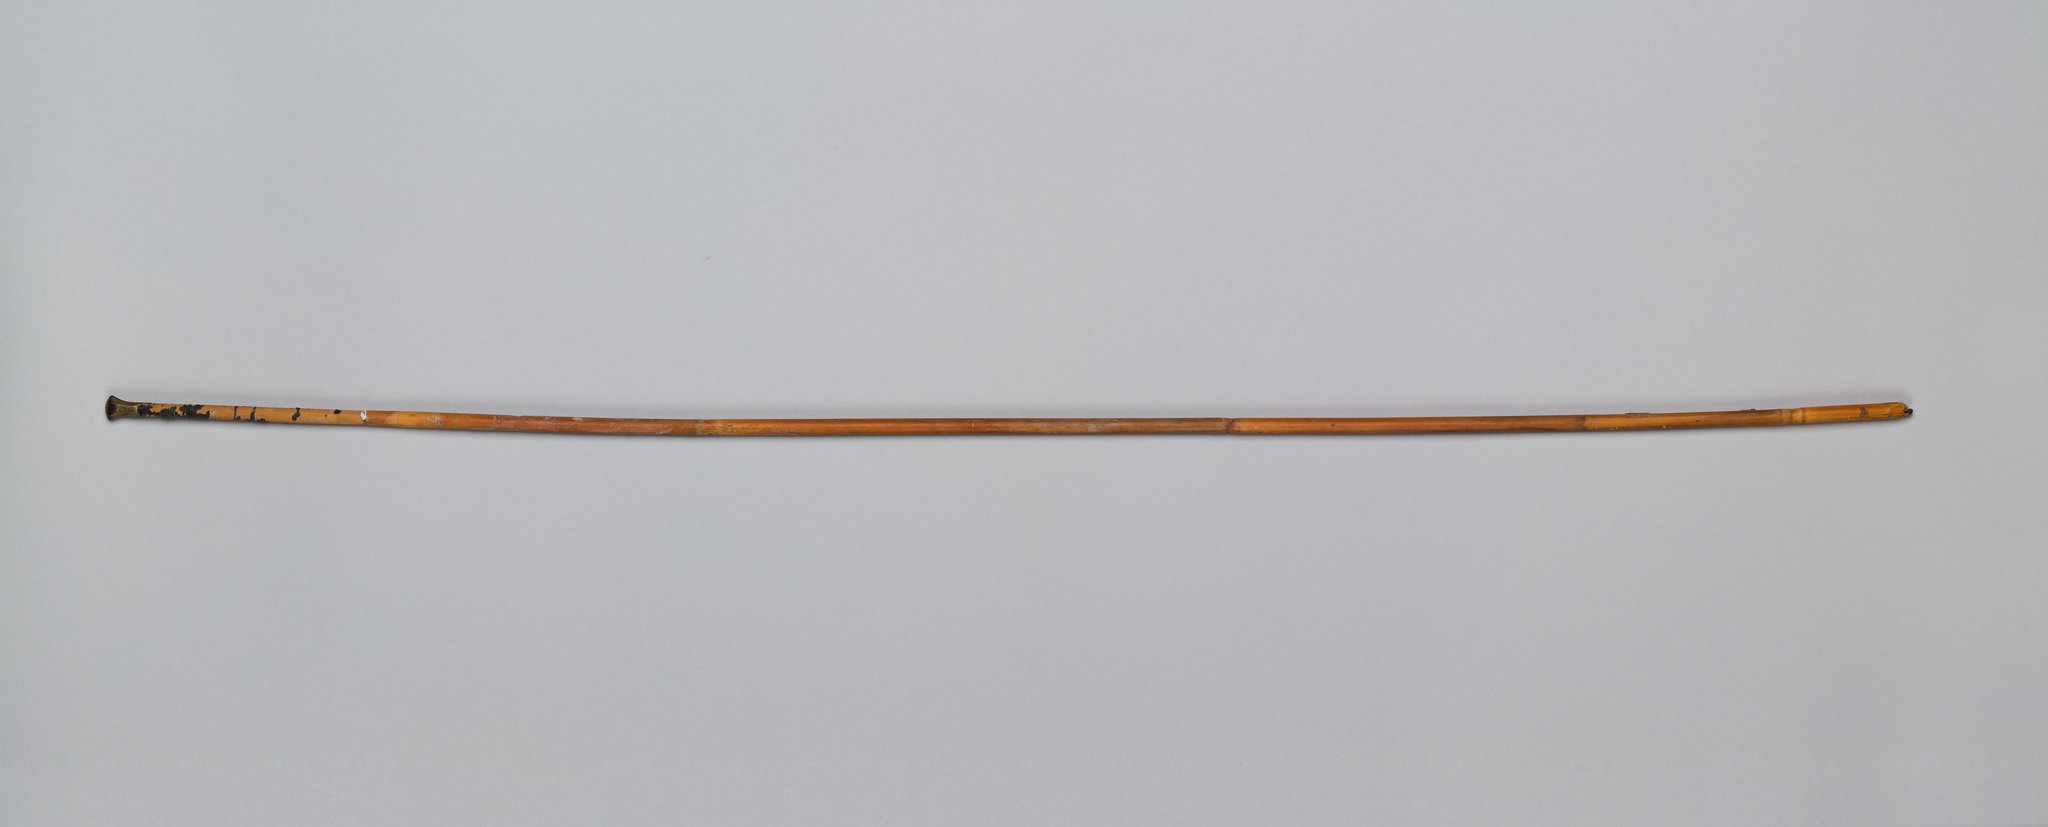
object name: spear, javelin, blunt pile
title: Blunt Pile and Shaft of a Javelin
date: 1479-1458 BCE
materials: bronze, copper alloy, wood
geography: egypt